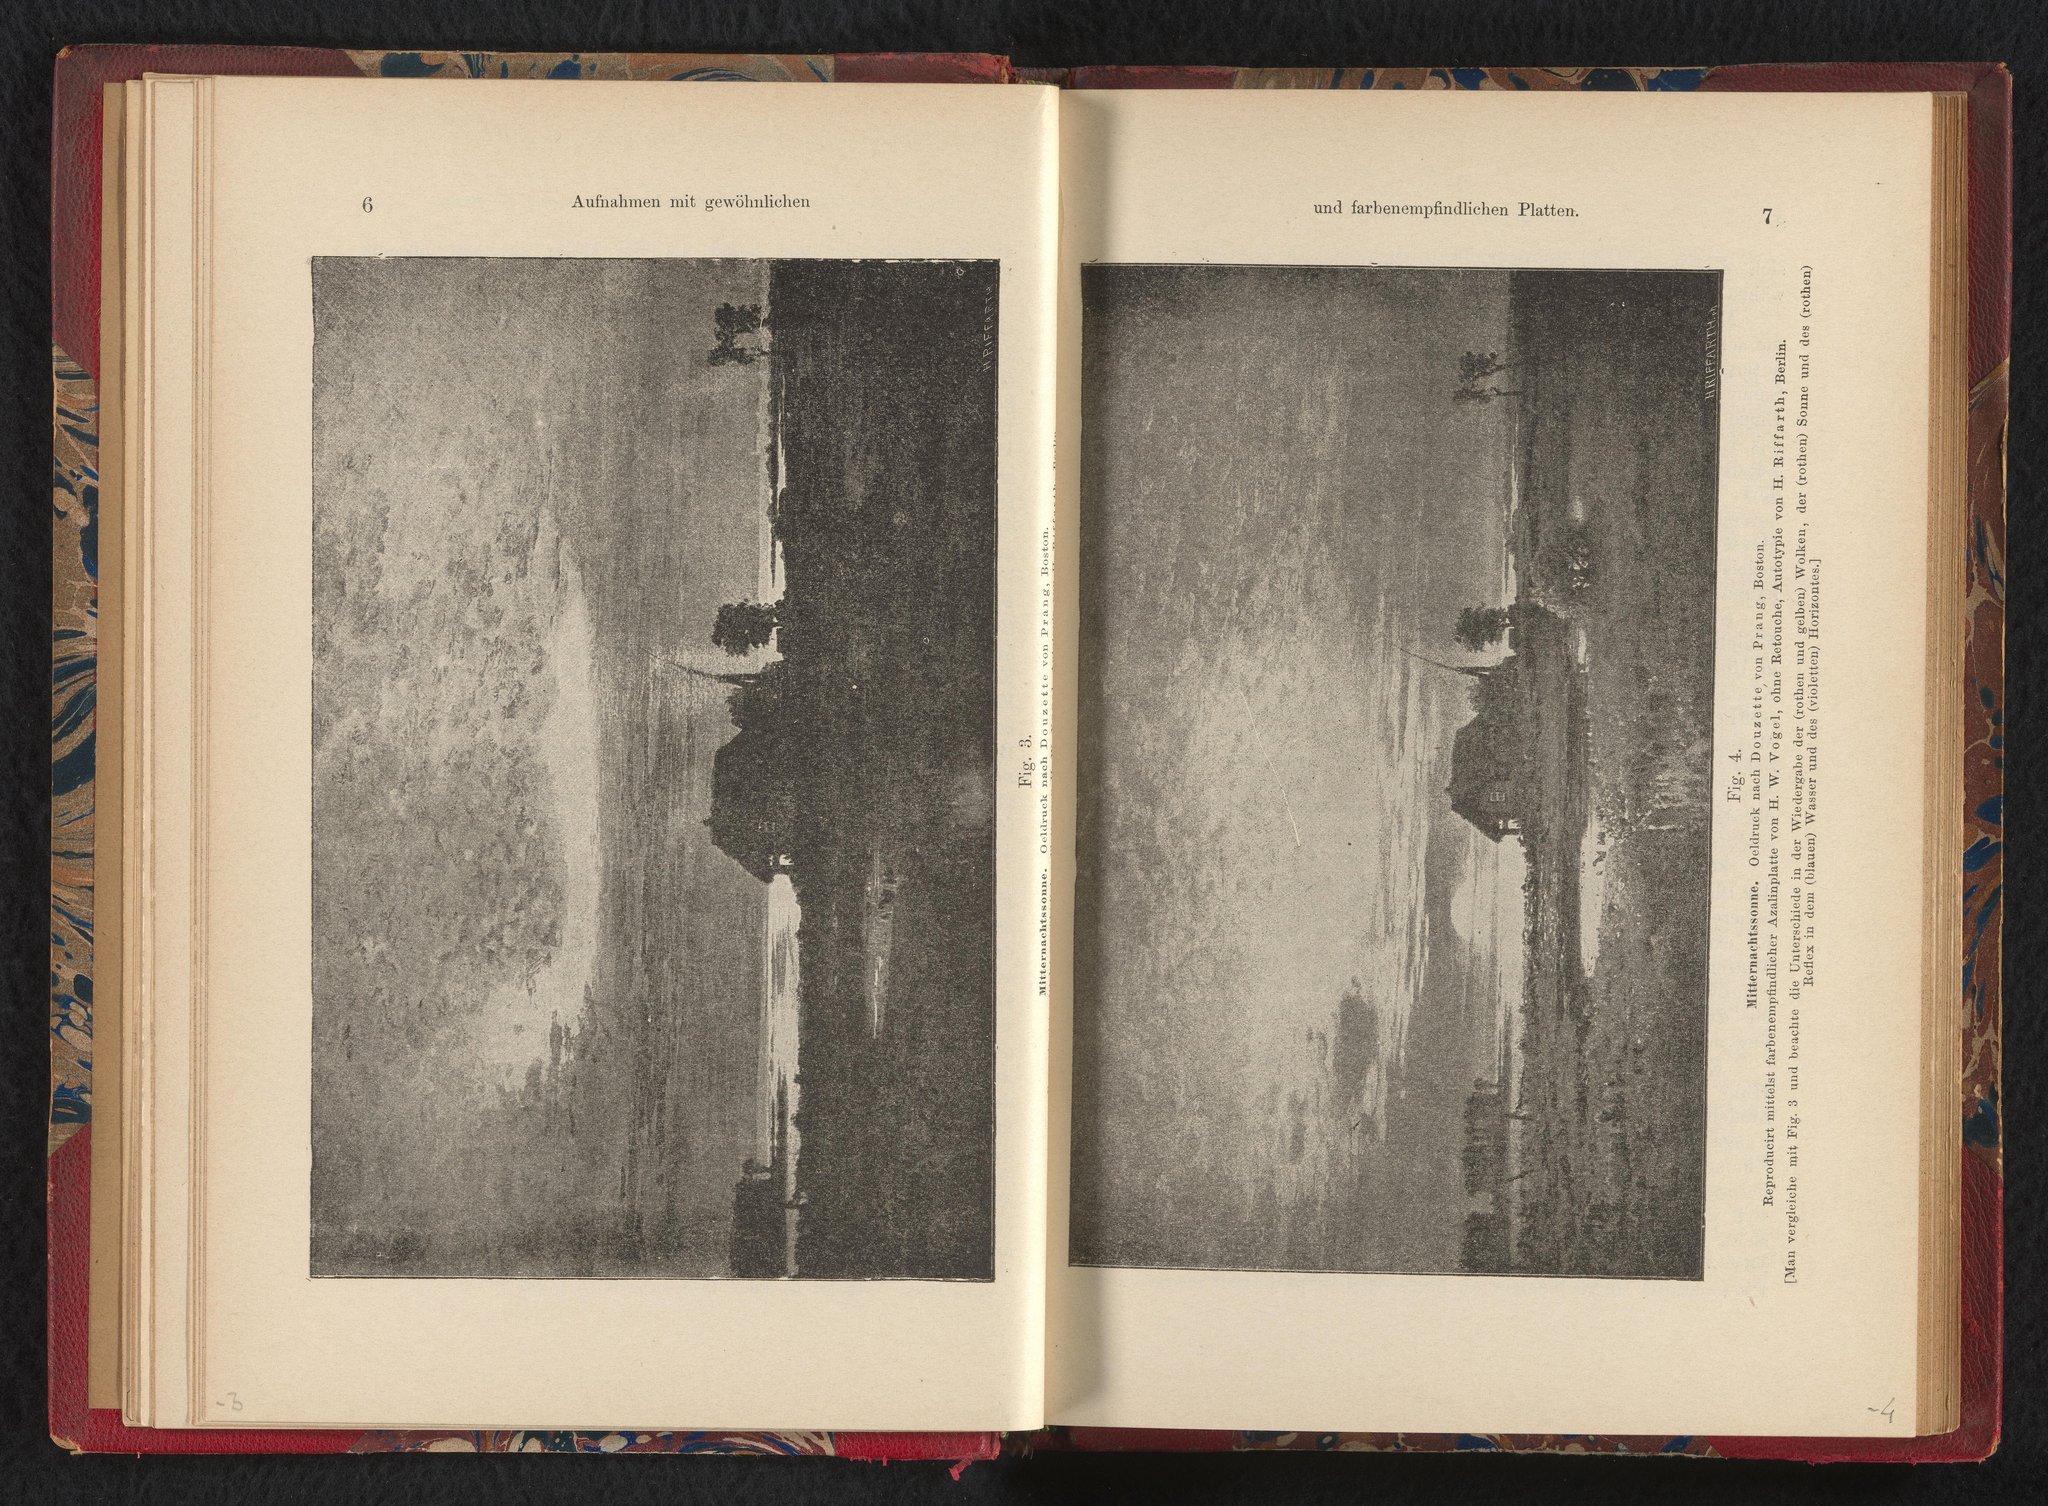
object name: page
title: Reproductie van het schilderij 'Mitternachtsonne' van Louis Douzette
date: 1886-1891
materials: paper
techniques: autotype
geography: berlin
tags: sunset, farm or solitary house in landscape